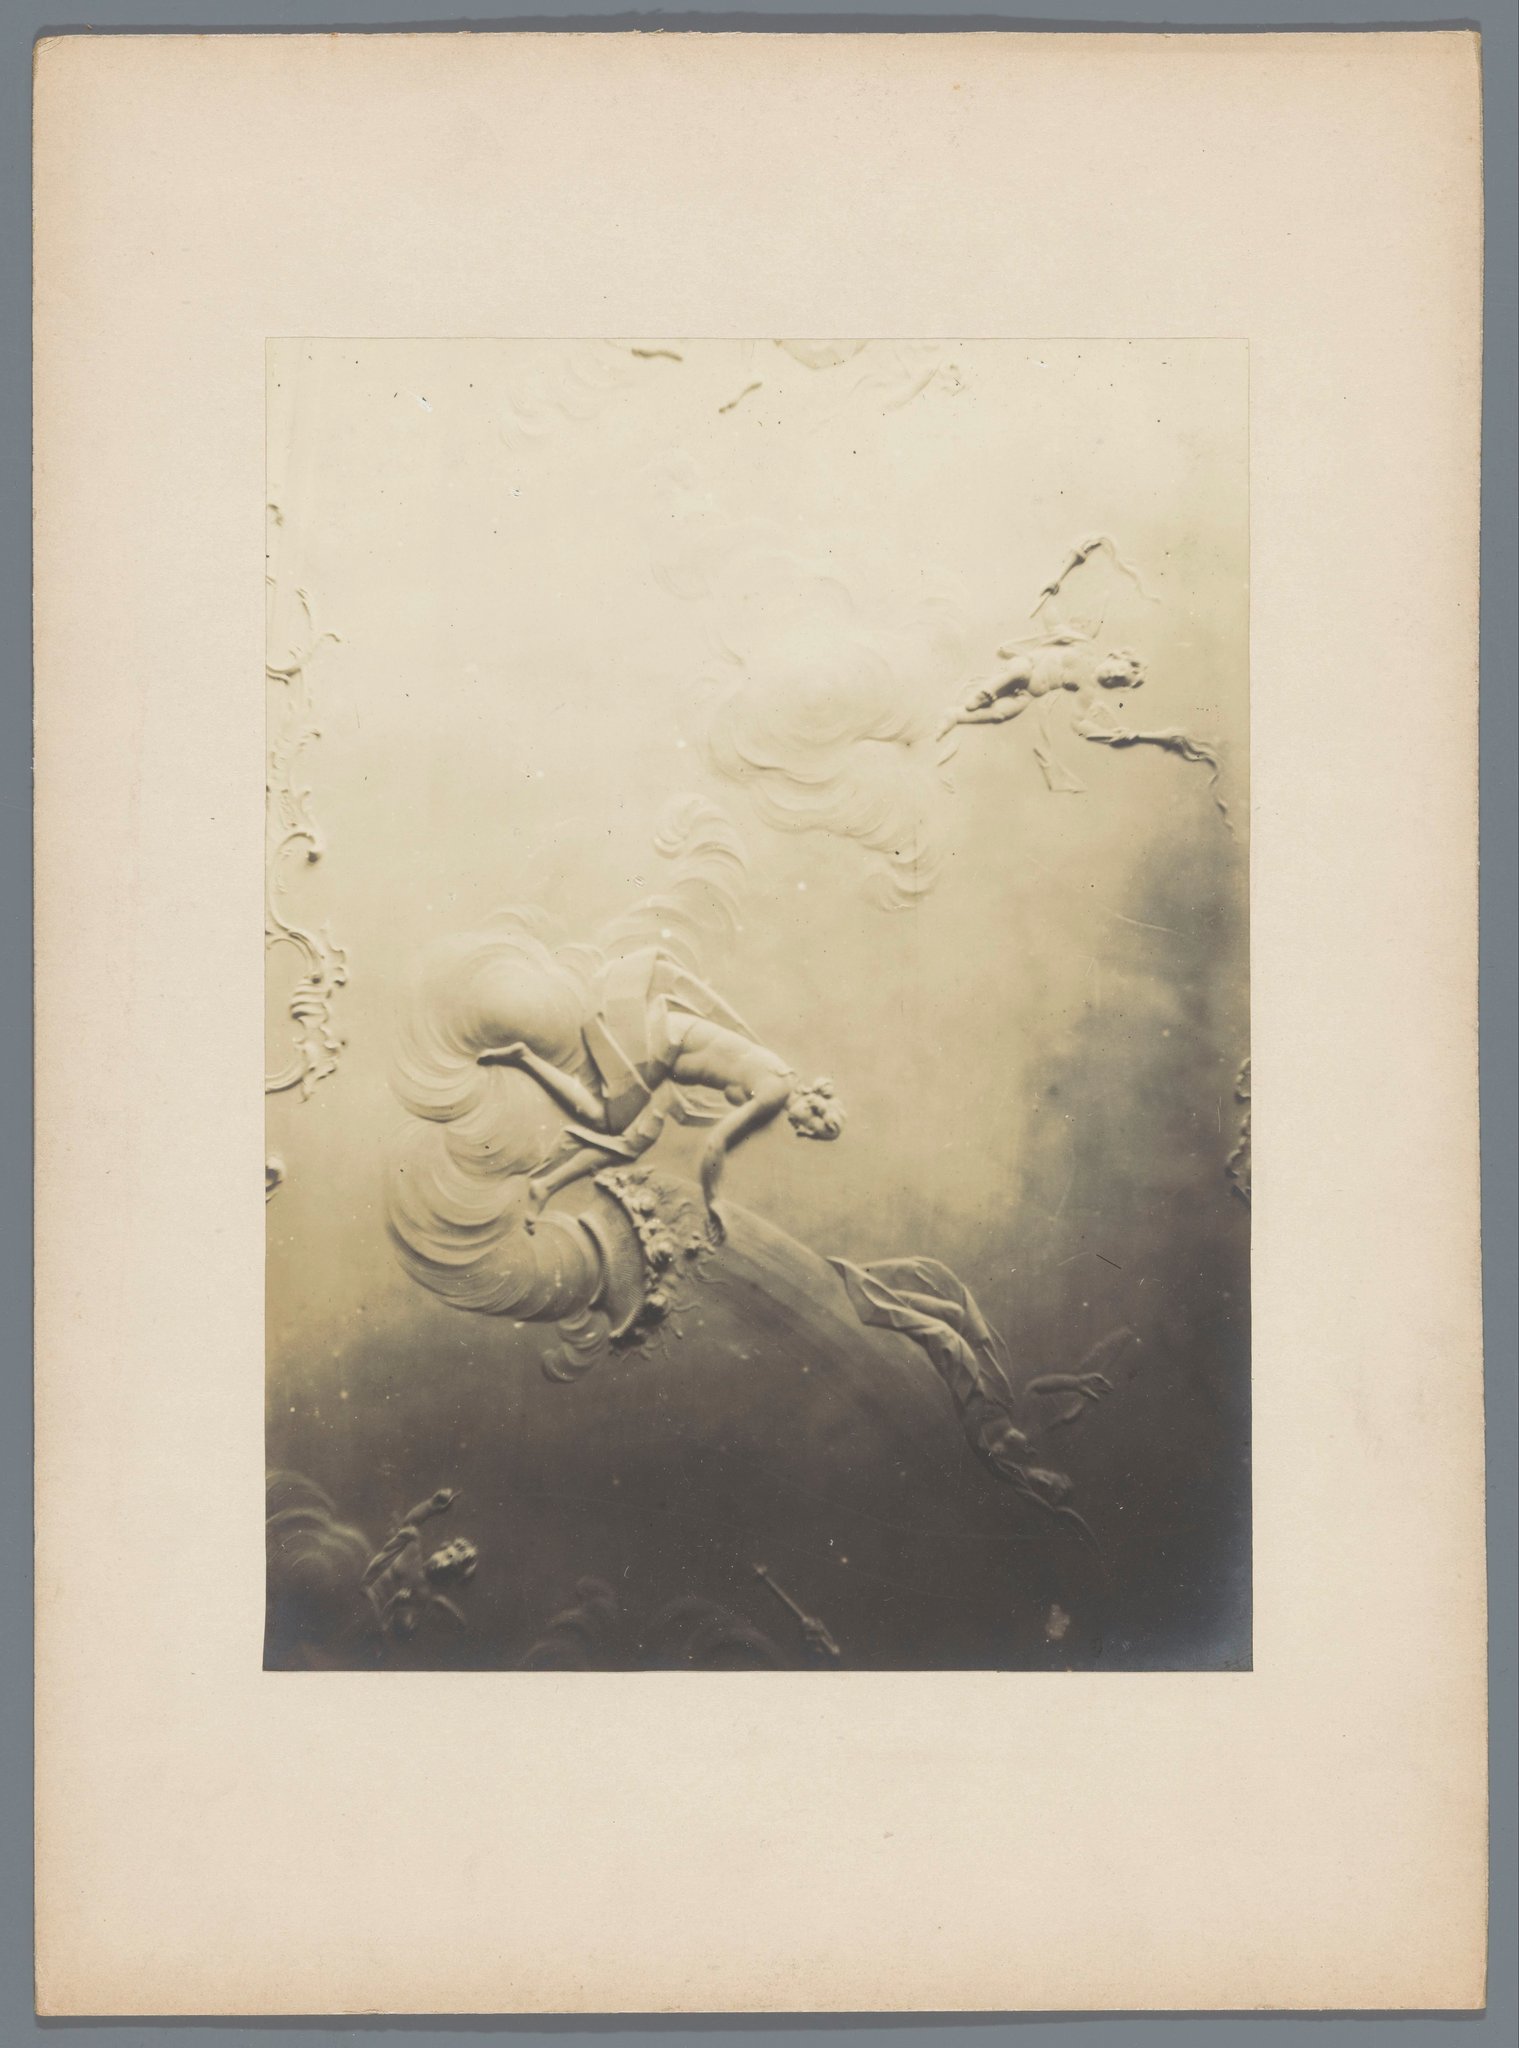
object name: photograph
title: Stuccoplafond in het huis aan de Wijnstraat 69 te Dordrecht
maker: Anonymous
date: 1900-1915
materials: cardboard, photographic support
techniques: gelatin silver print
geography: wijnstraat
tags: angel(s) with torch, (decorated) ceiling, interior ~ representation of a building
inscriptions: annotation, inscription: ‘Dordrecht. Z-H. Huis Wijnstraat 69.’, inscription: ‘neg. no 14543 foto no 5791’